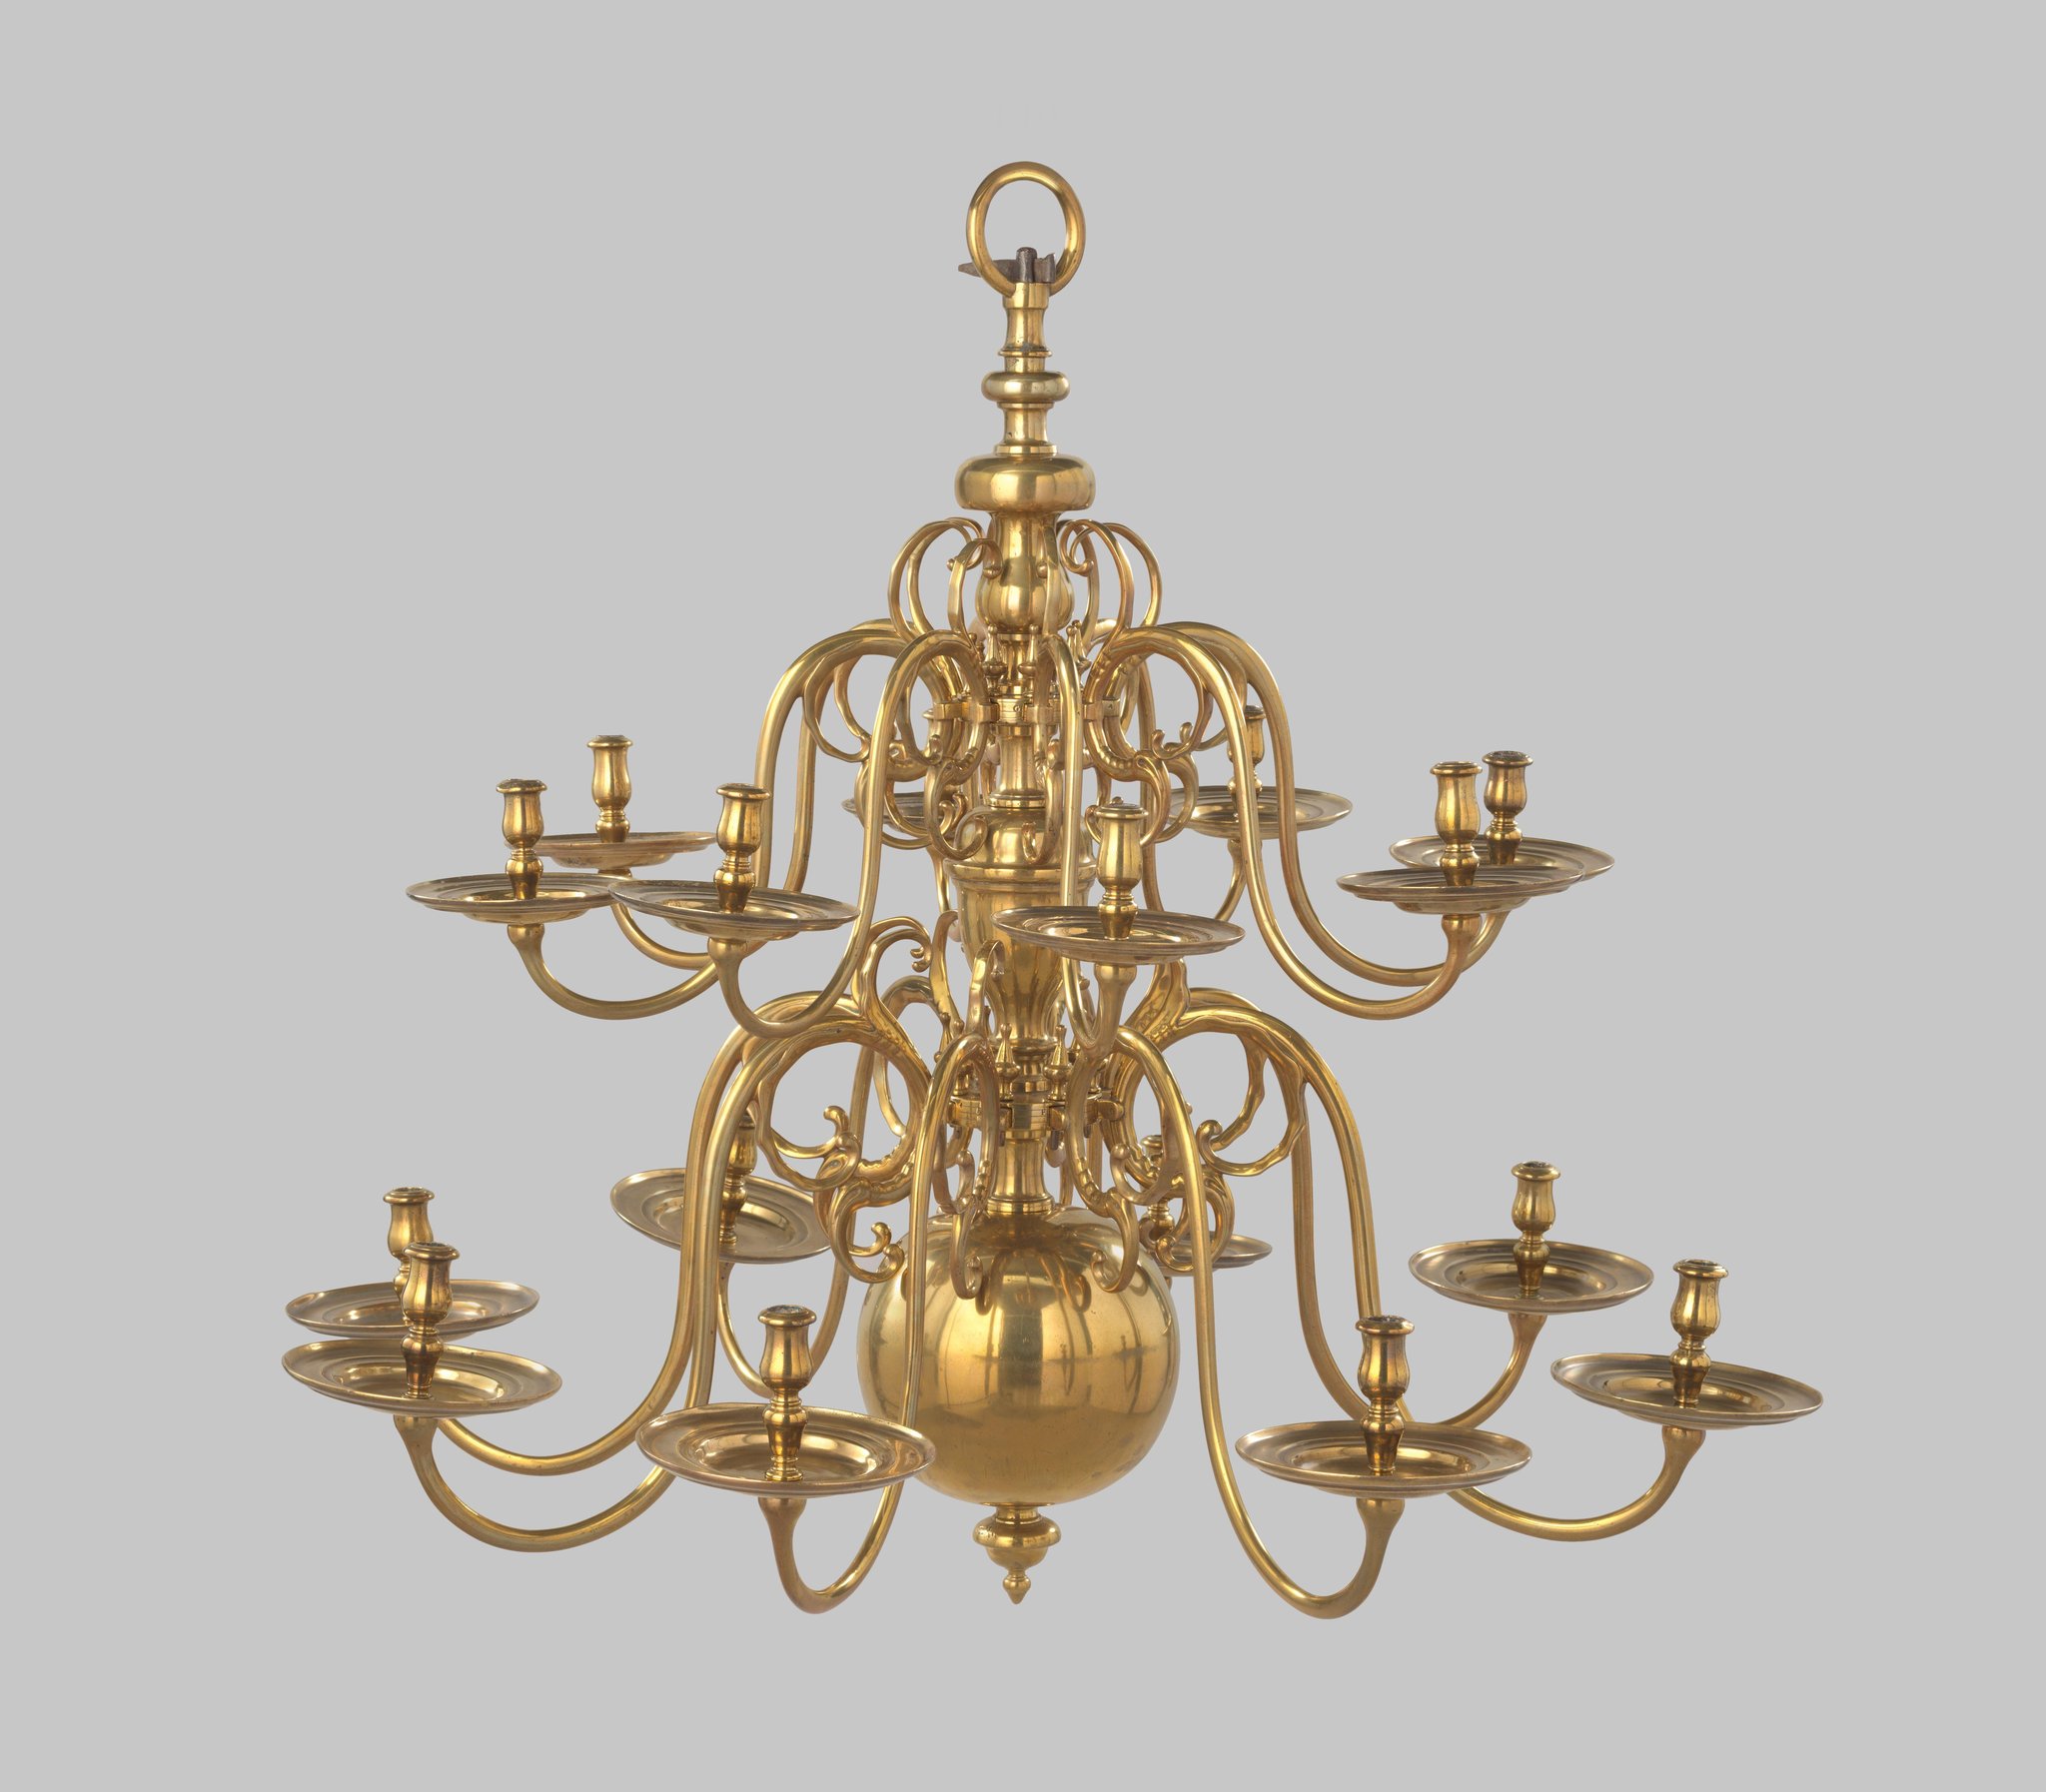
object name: chandelier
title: Arm van een kaarsenkroon in twee hoogten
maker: Anonymous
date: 1650-1675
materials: brass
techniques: screwed, turning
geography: amsterdam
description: De S-vormige arm is aan de stamzijde voorzien van een nok met een opening om deze met een pin in de standring te kunnen vastzetten. Bij de stam is de arm op het eind versierd met een gestileerde dolfijnenkop en met twee krullen, waarvan de vormgeving aan het kwabornament is ontleend. Naar buiten toe eindigt de arm in een verdikking, waarin een van een schroefdraad voorzien gat is aangebracht ter bevestiging van de kaarsenhouder met de vetvanger. De arm is met behulp van hetzelfde model gegoten als de overige armen van de krans en heeft dezelfe grootte. De kaarsenhouder heeft een ronde zich naar boven toe versmallende en in een uitstekende rand overgaande vaasvorm op balustervoet met een van een schroefdraad voorzien eind, waarin onderaan het centergat. De vetvanger is aan de bovenkant naar het midden toe één keer verdiept. Aan de onderkant is zij geprofileerd op de rand en rond het gat op het enigszins bolvormige midden. De vetvanger heeft telkens zijn eigen grootte en is met behulp van hetzelfde model gegoten als de overige vetvangers van deze krans. De pin is voorzien van een knop in vaasvorm. Dit is de eerste arm van de onderste standring, genummerd op de nok met de letter A.